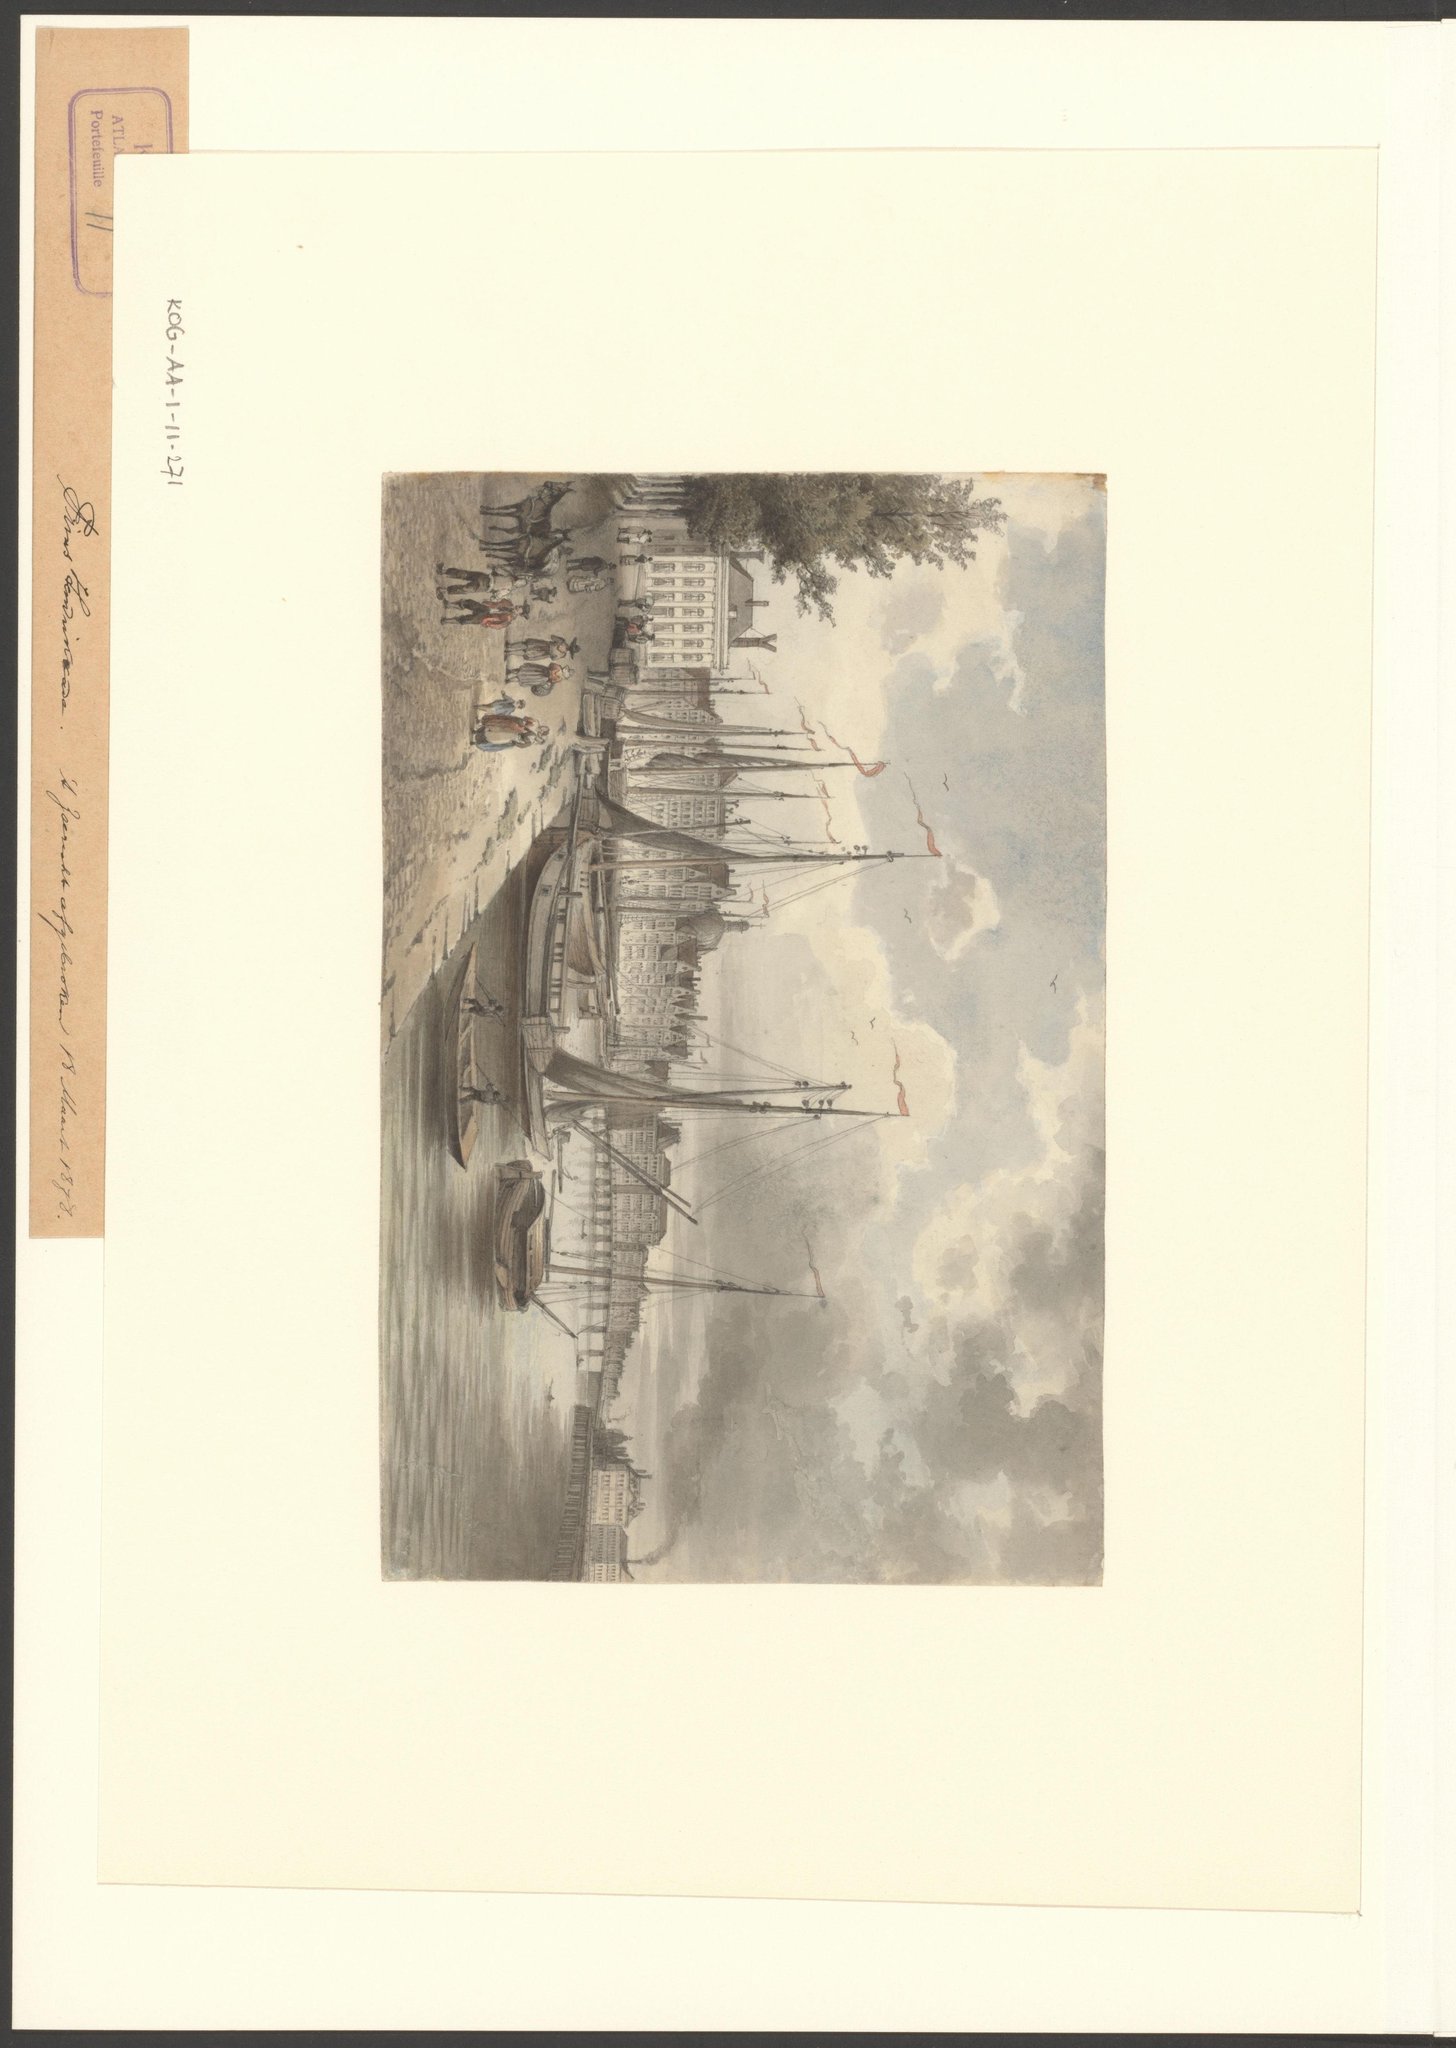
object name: drawing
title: Gezicht op de Oude Teertuinen, gezien vanaf het Kamperhoofd naar het Zeerecht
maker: Anonymous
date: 1800-1878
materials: ink, paper, pencil, watercolor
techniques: brush, pen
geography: amsterdam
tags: sailing-ship, sailing-boat, city-view in general; 'veduta', river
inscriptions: inscription: ‘Rehback (?)’, collector's mark: ‘11’ Lugt 1641b, inscription: ‘Prins Hendrikkade. 't Zeerecht afgebroken 18 Maart 1878.’, inscription: ‘Port. 11-271’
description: Onderwerpsrubriek binnen de Atlas Amsterdam: Prinsengracht, Korte Prinsengracht, Prins Hendrikkade.